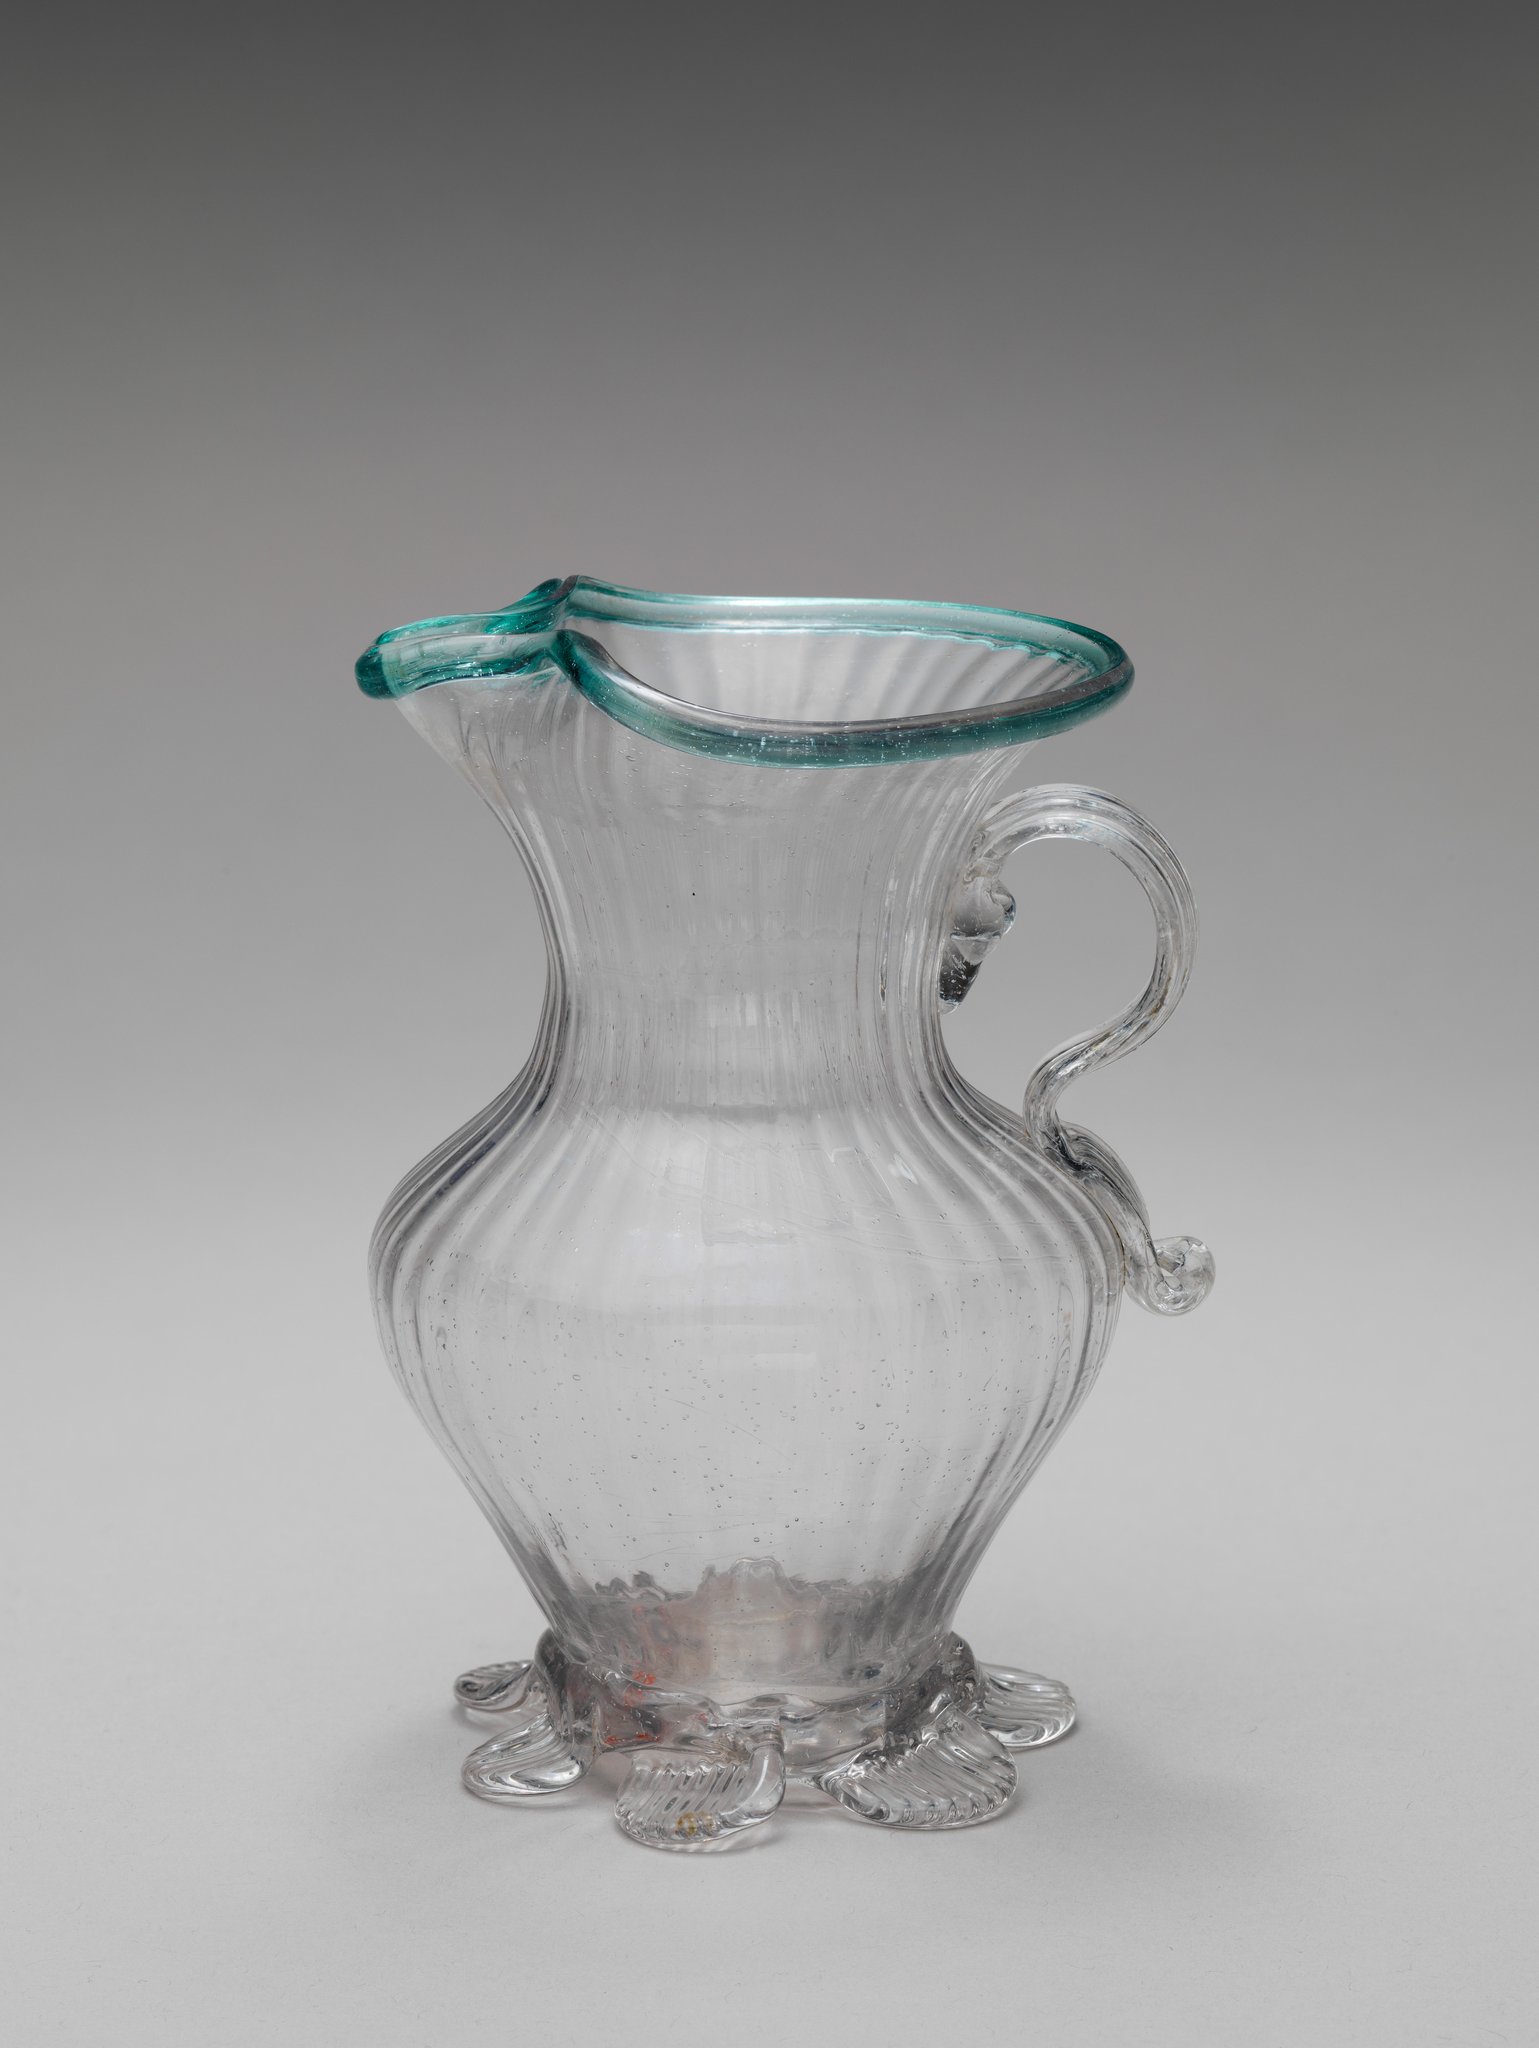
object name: jug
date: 1601-1800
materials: glass